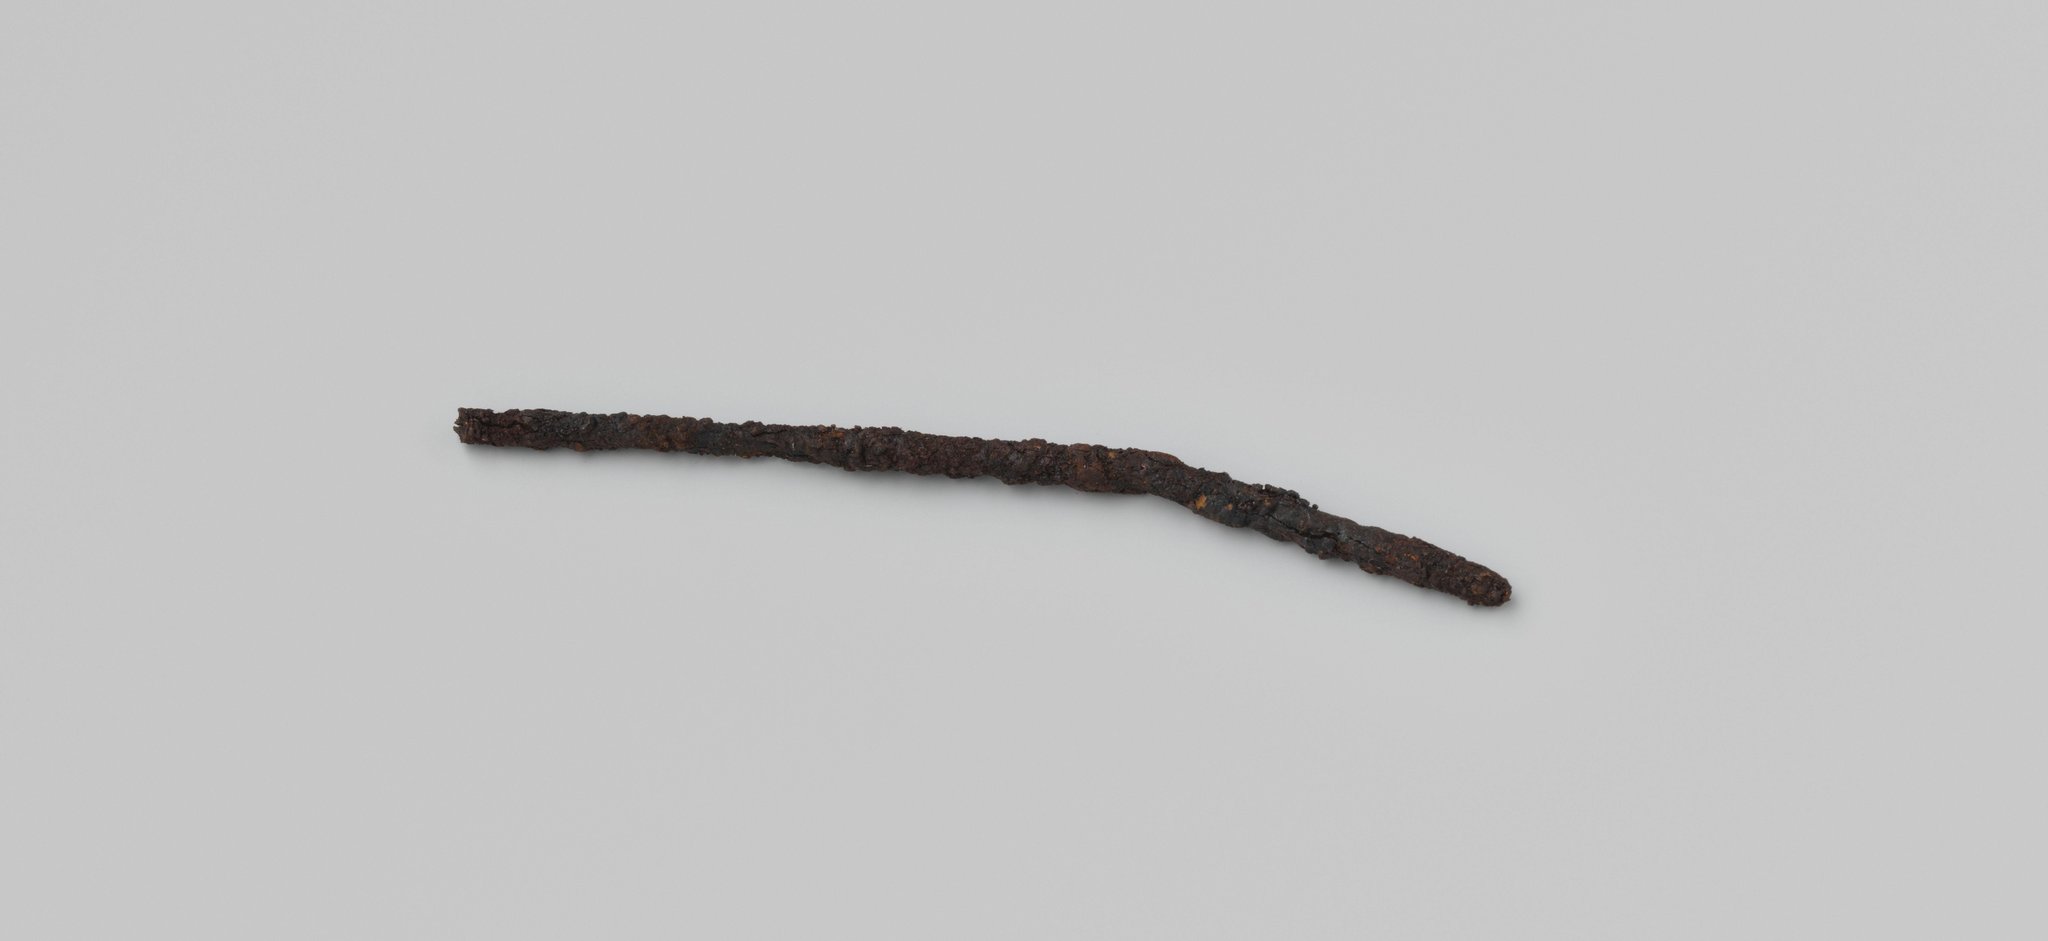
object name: part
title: Fragment of onderdeel uit het wrak van de Oost-Indiëvaarder Hollandia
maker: Anonymous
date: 1743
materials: iron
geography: netherlands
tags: verenigde oostindische compagnie, hollandia (schip), annet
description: Varied parts or fragments, bar(-shaped) fragments; fragm, heavily eroded, broken.